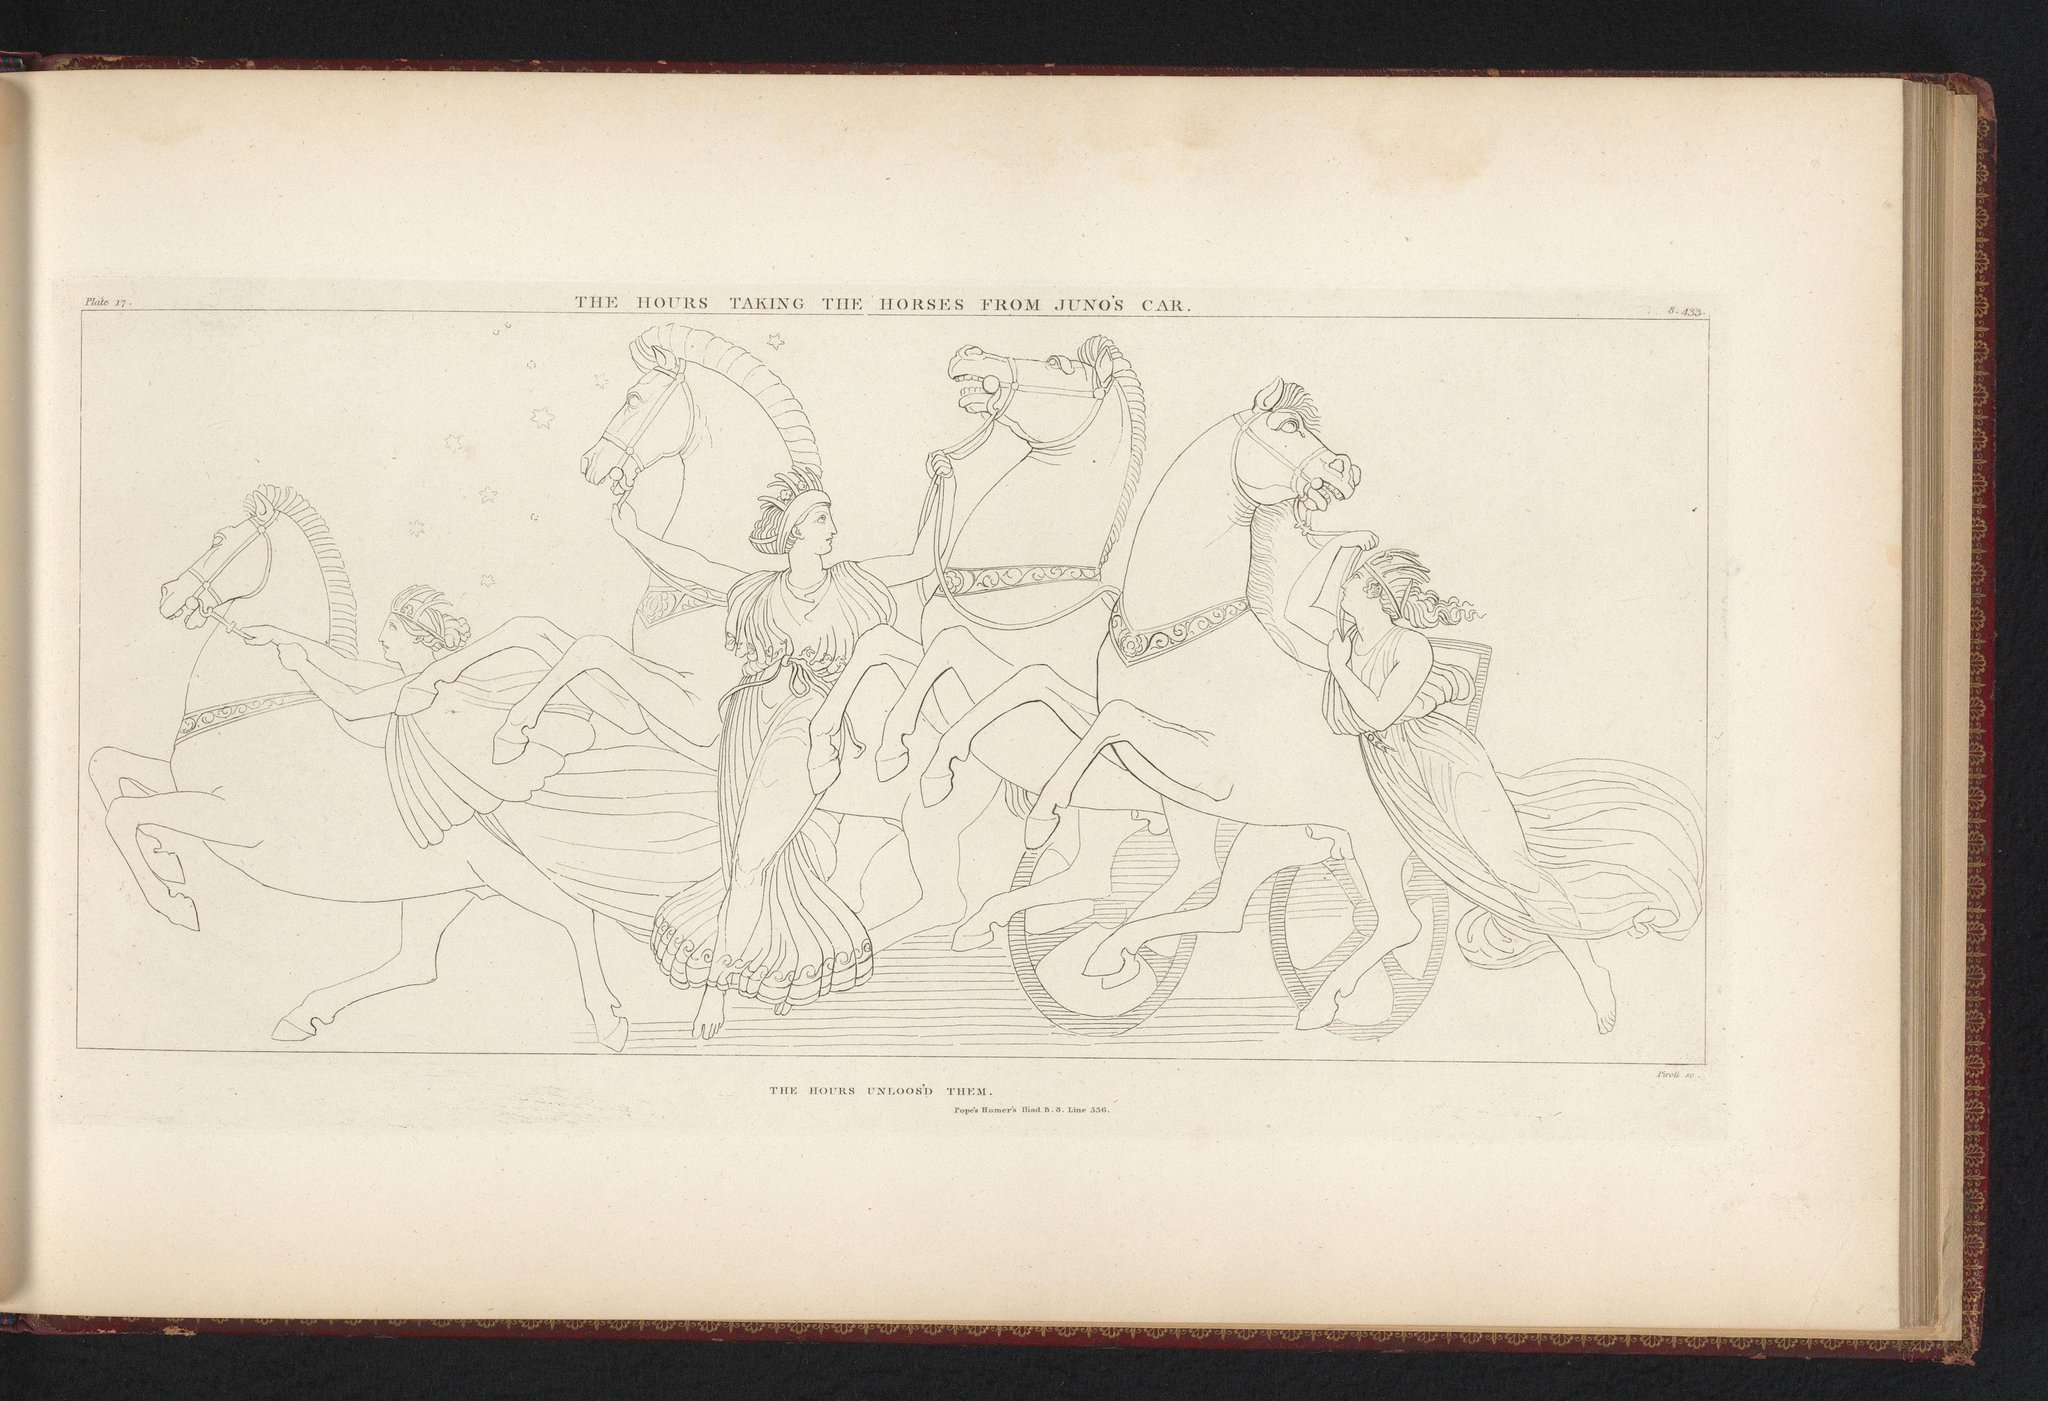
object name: print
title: Ilias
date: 1805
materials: paper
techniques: etching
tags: chariot, triumphal car, juno raised by the hours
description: Prent maakt onderdeel uit van een serie met 39 prenten over de Ilias, geschreven door Homerus.